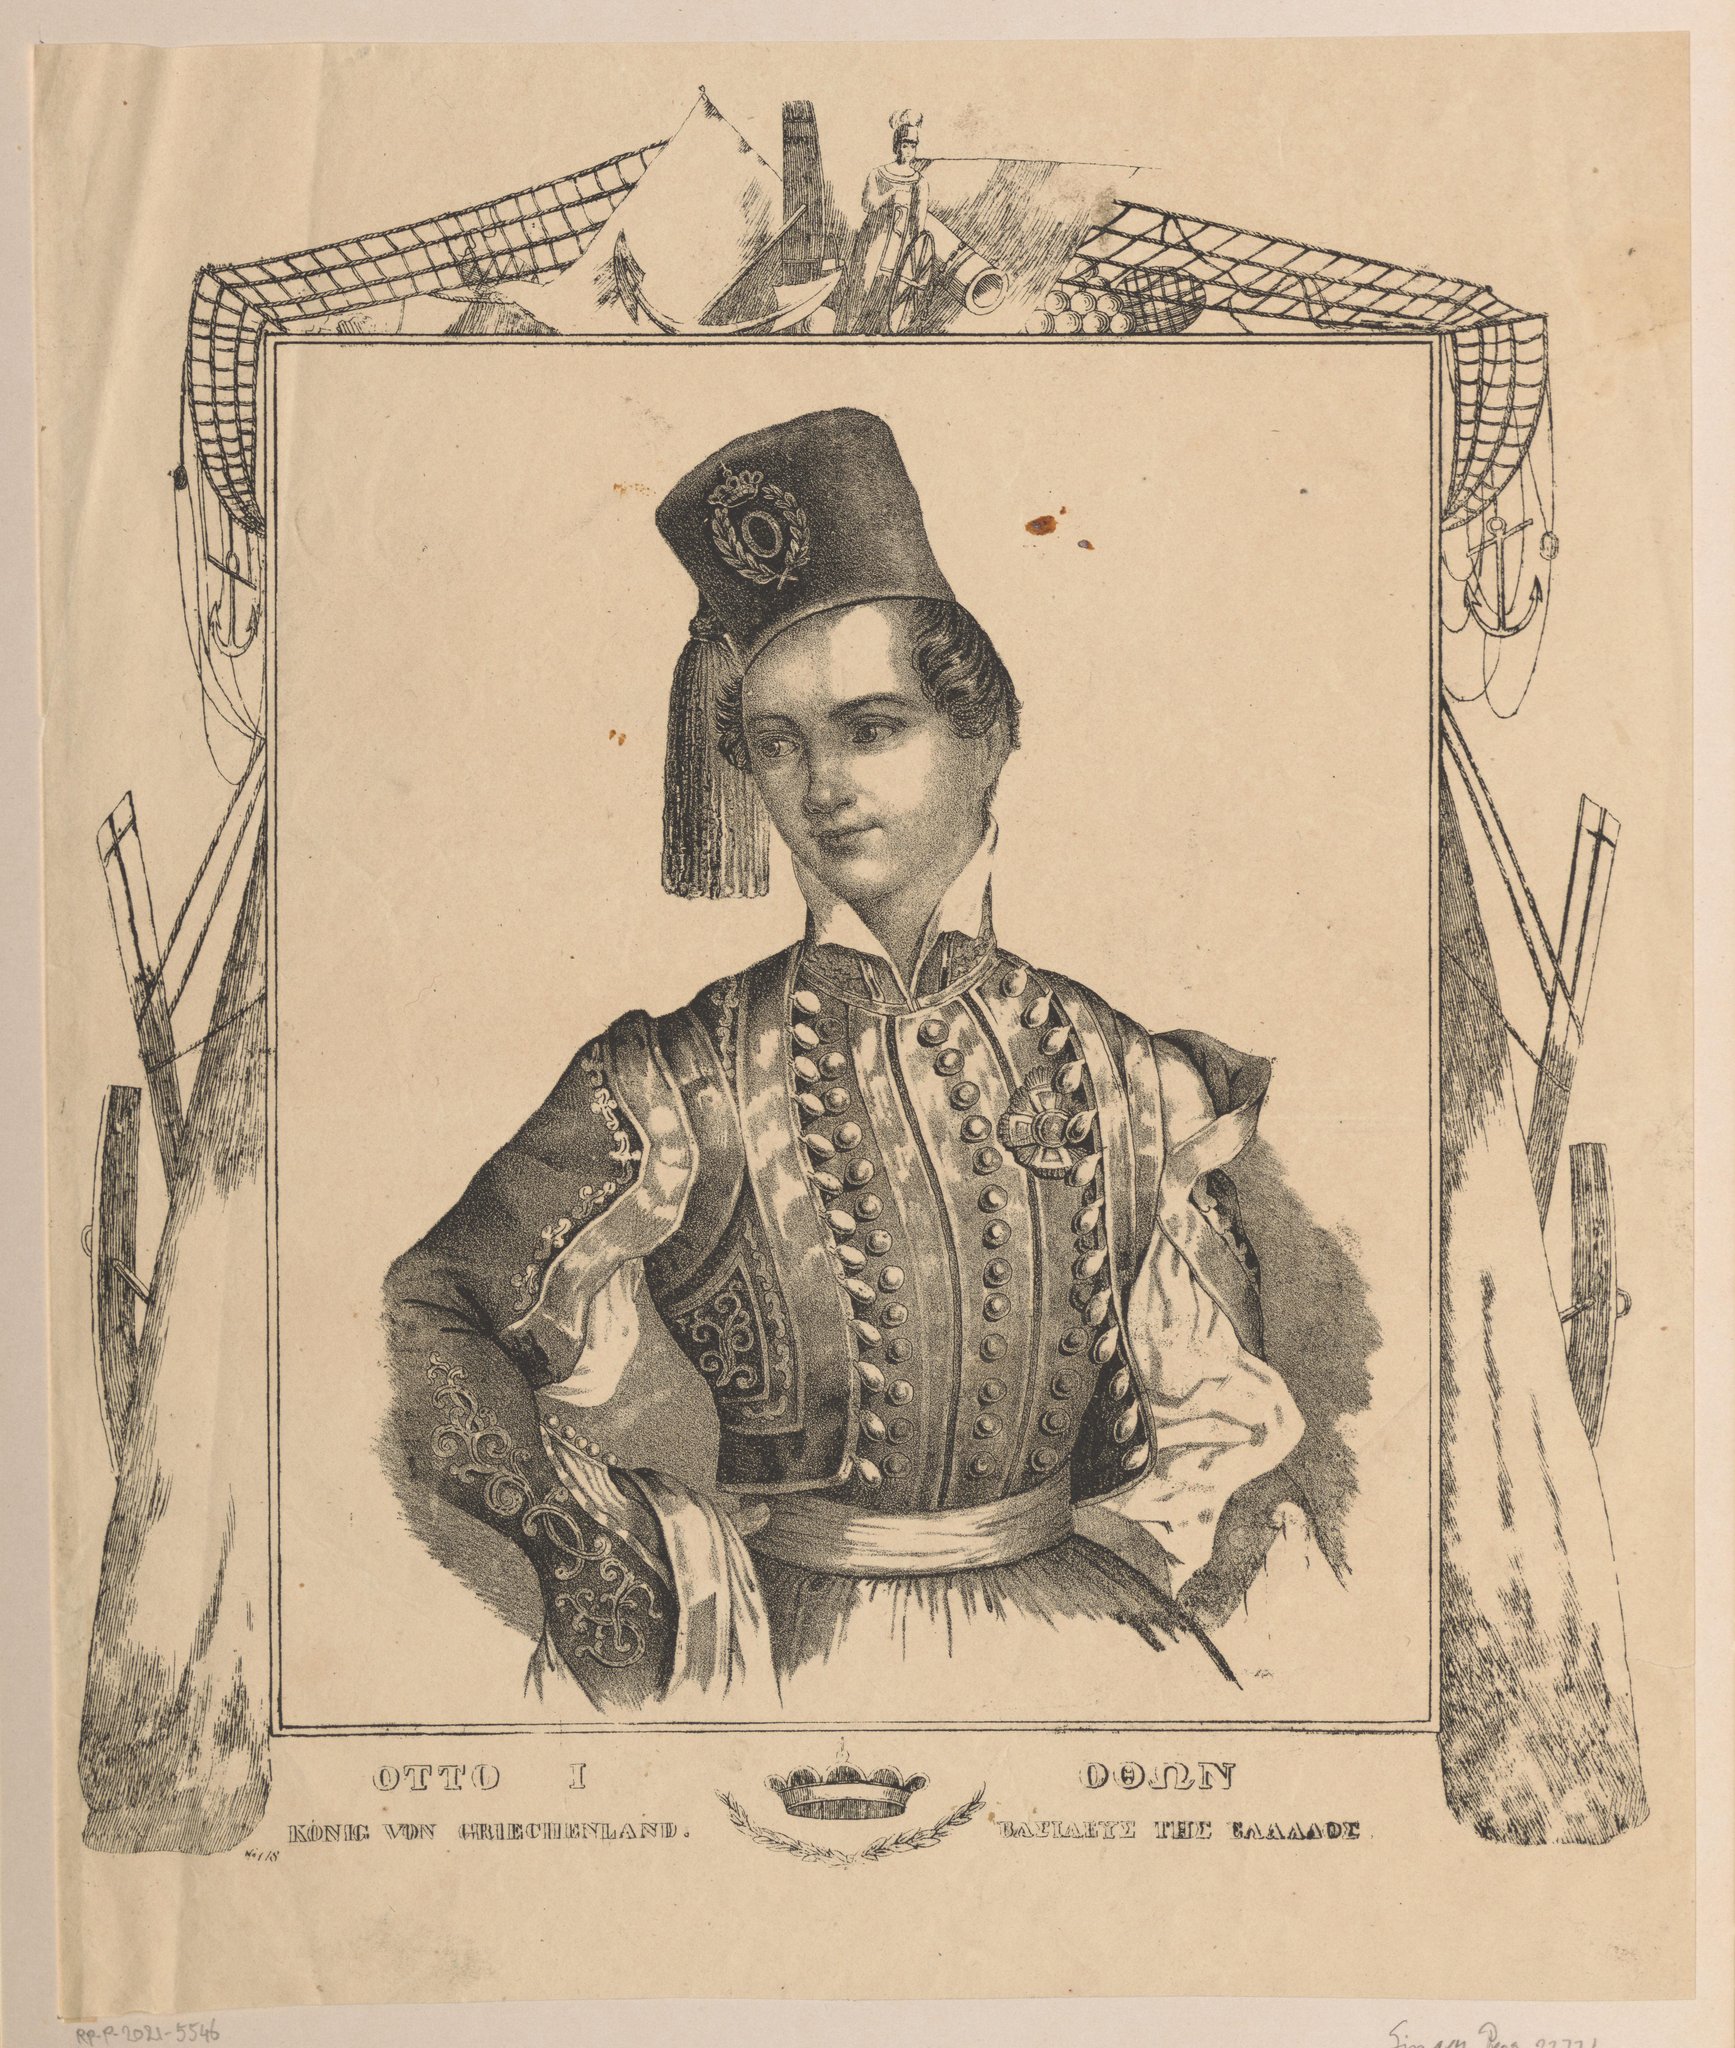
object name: print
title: Portret van Otto I, koning van Griekenland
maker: Anonymous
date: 1832-1899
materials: paper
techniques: lithograph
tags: historical persons, firearms: cannon, parts of ship's exterior: anchor, king